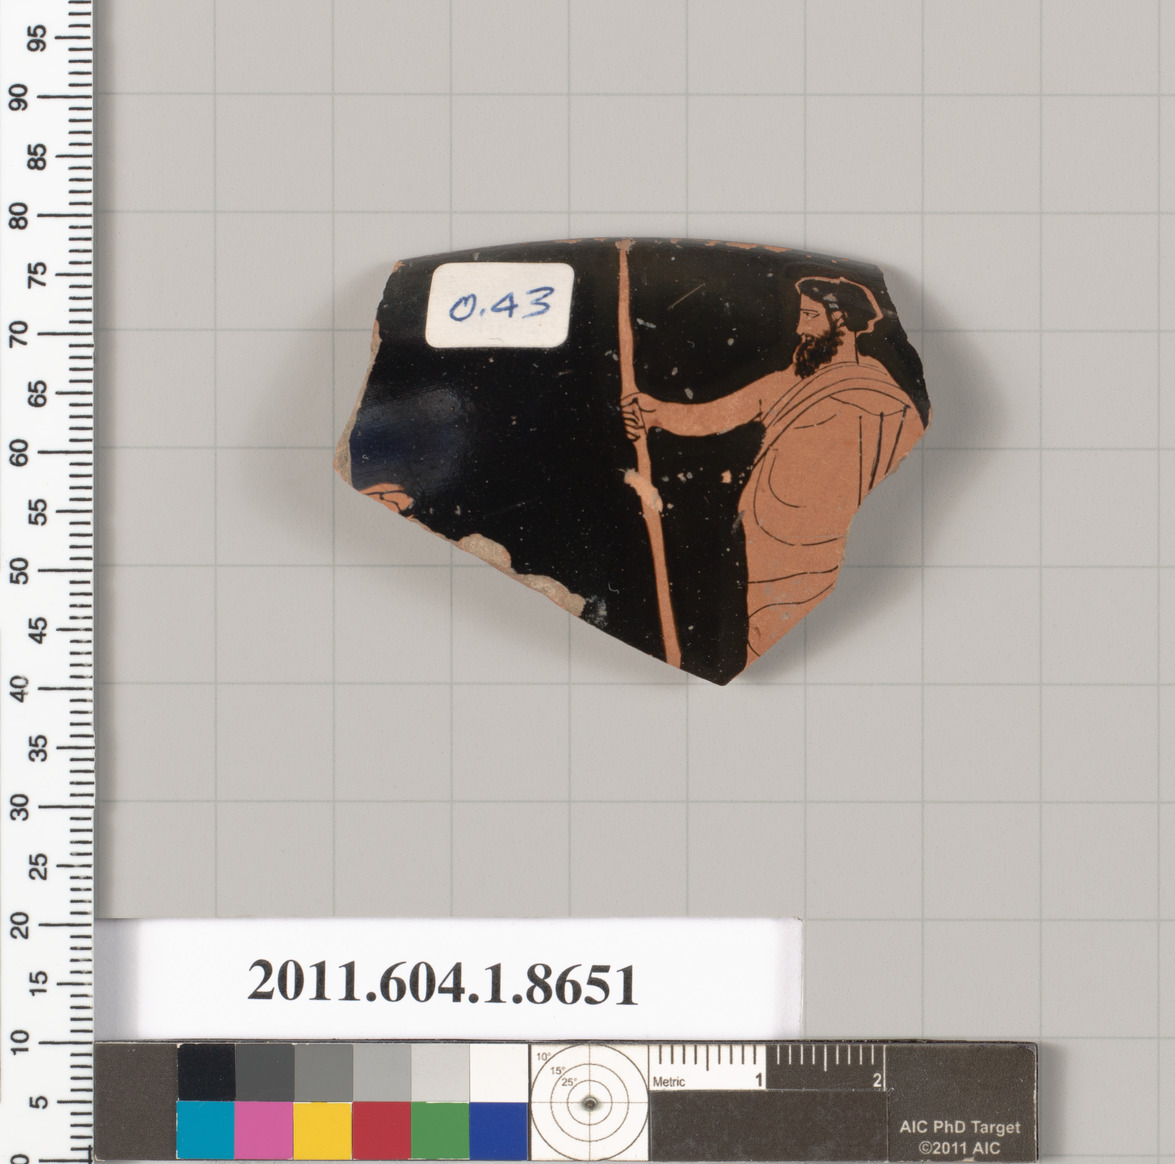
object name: kylix fragment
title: Terracotta rim fragment of a stemless? kylix (drinking cup)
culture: greek, attic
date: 467-435 BCE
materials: terracotta